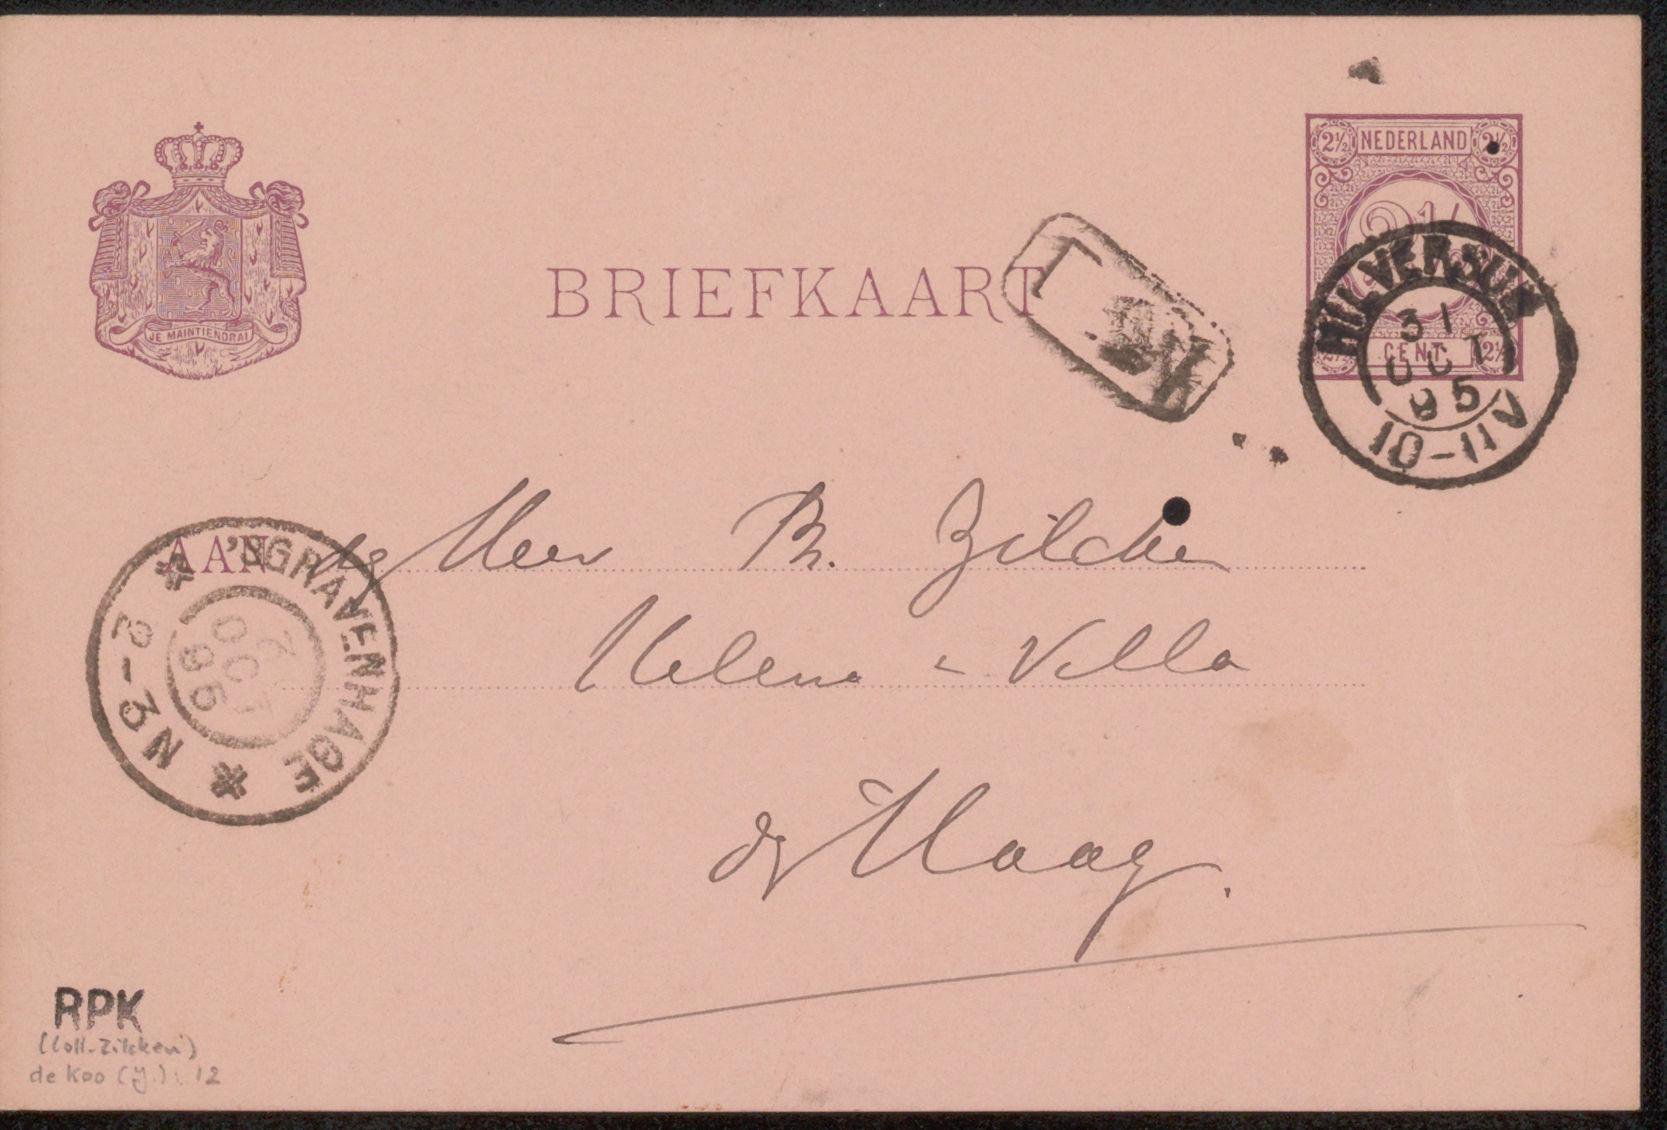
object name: postcard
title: Briefkaart aan Philip Zilcken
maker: johannes de koo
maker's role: auteur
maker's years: 1841-1909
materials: cardboard, ink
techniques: pen, writing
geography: hilversum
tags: adriaan willem weissman, the hague, painter, philip zilcken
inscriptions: collector's mark: ‘RPK’